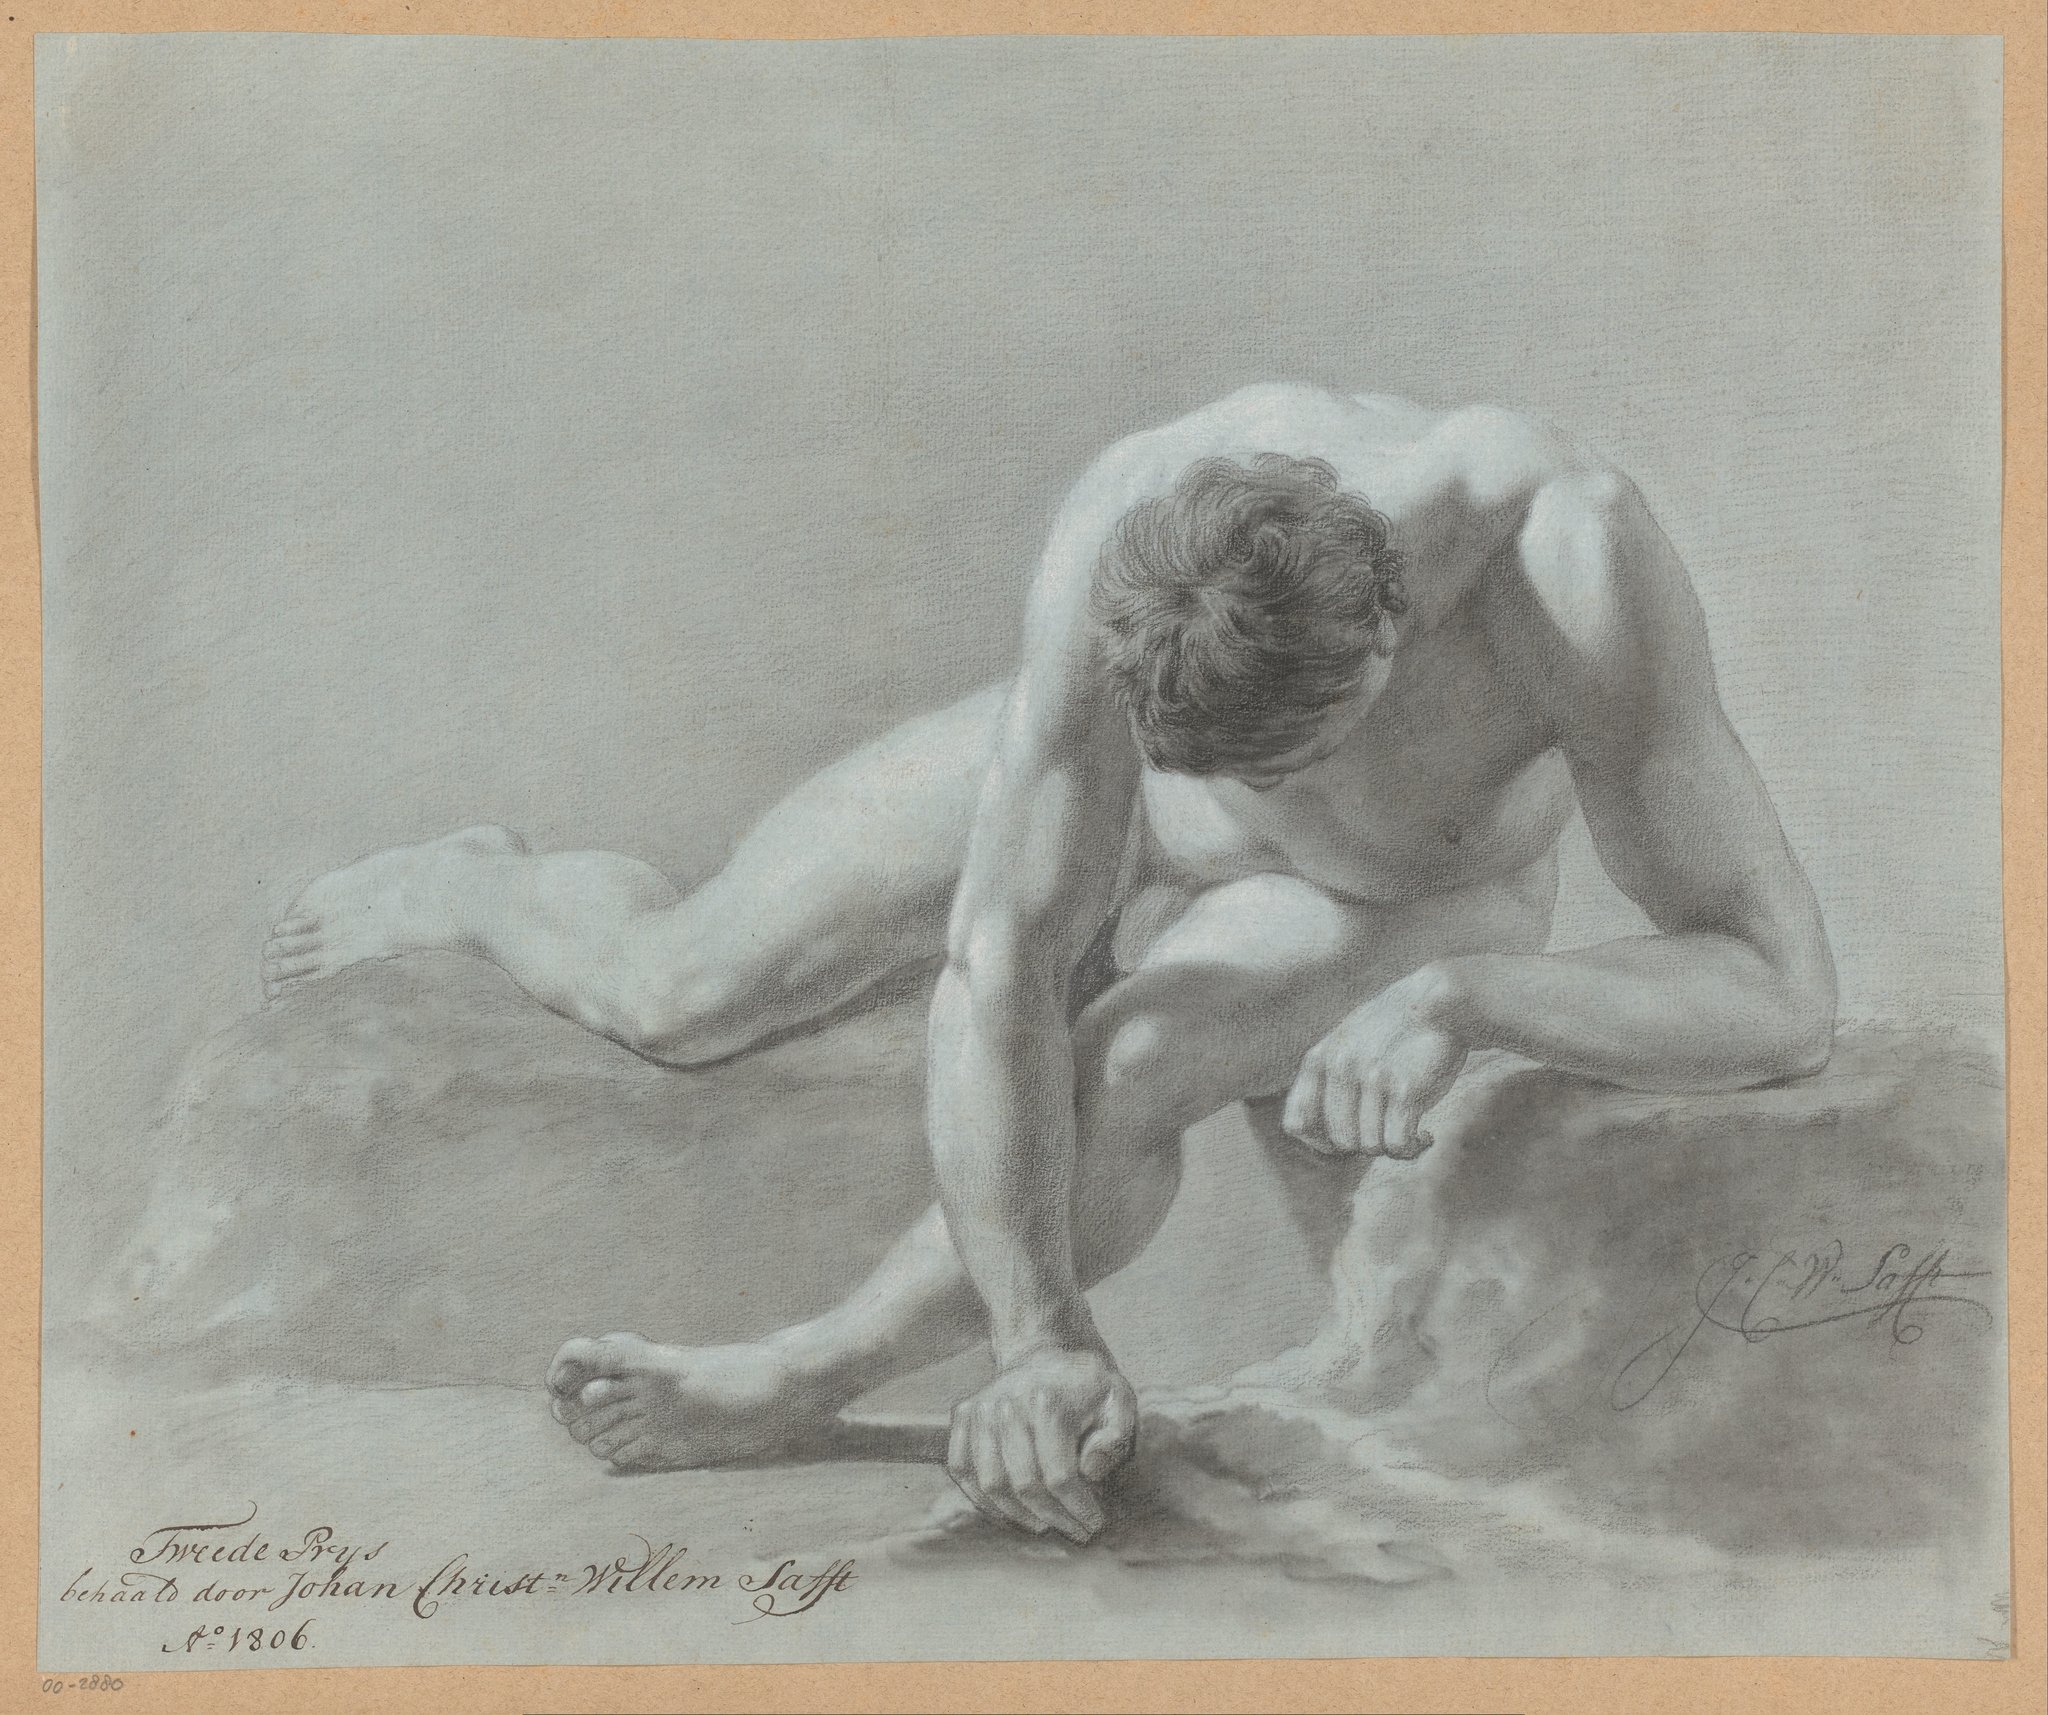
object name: drawing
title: Voorovergebogen zittend mannelijk naakt (2e prijs 1806)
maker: johan christiaan willem safft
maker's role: draughtsman, print maker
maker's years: 1778-1849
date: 1806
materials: chalk, paper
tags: sitting figure (+ nude human being)